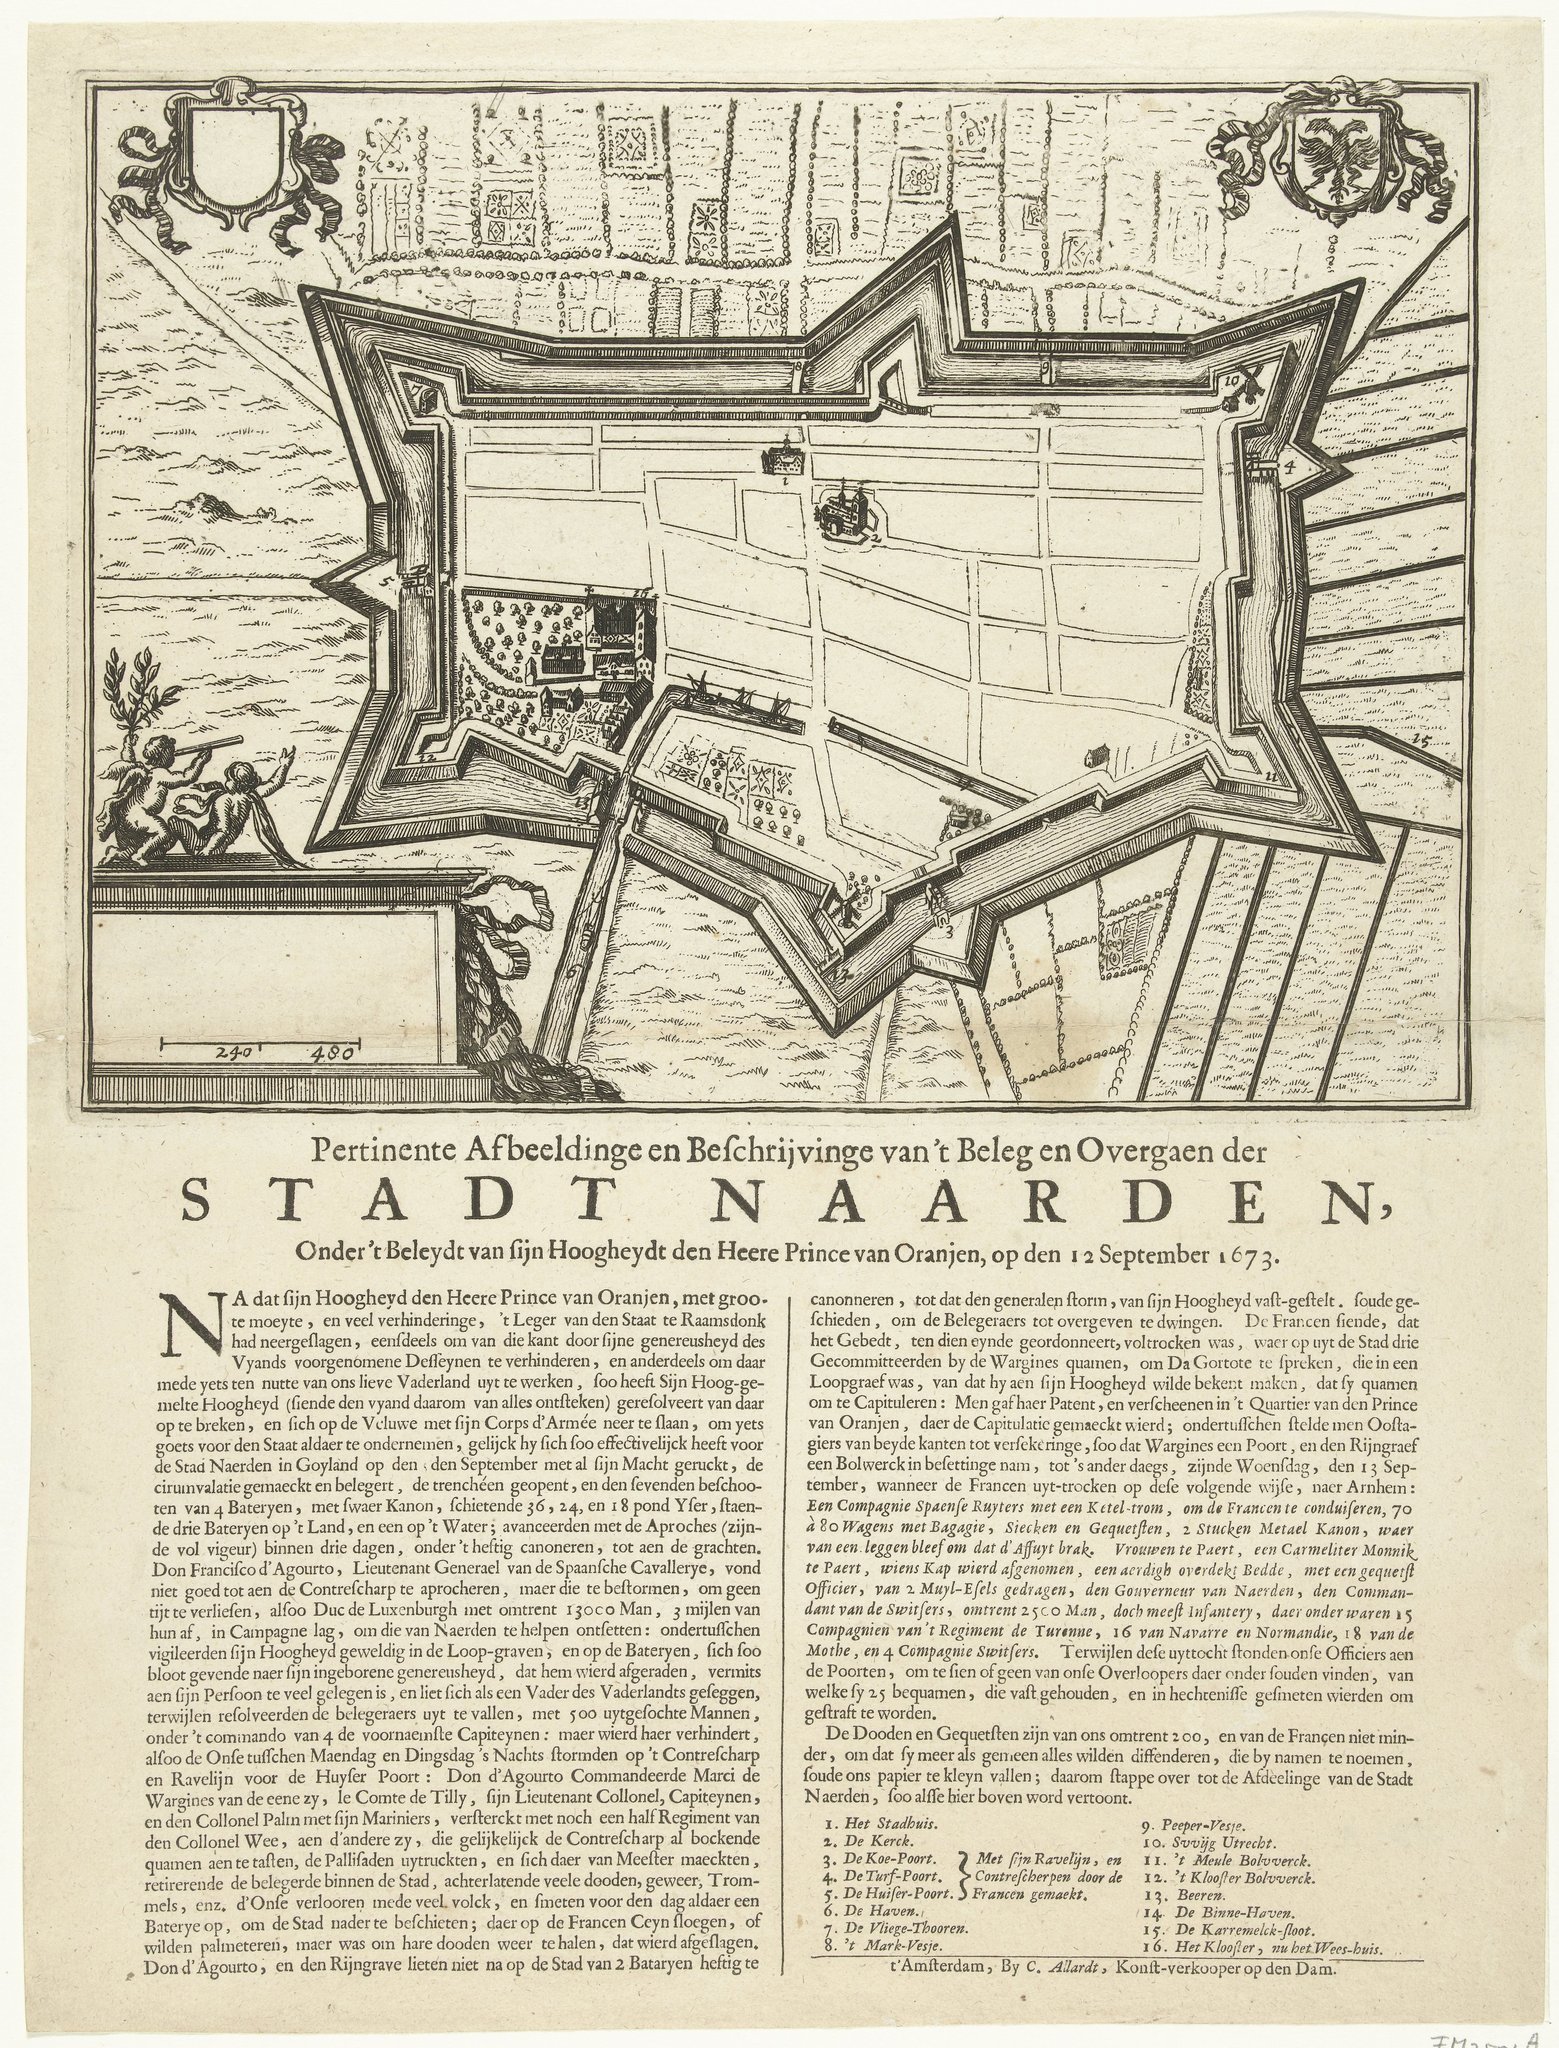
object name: print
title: Pertinente Afbeeldinge en Beschrijvinge van 't Beleg en Overgaen der Stadt Naerden, Onder 't Beleydt van sijn Hoogheydt den Heere Prince van Oranjen, op den 12 September 1673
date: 1673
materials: paper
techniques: etching, letterpress printing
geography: amsterdam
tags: the hague, william iii (prince of orange and king of england, scotland, and ireland), maps of cities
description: Plattegrond van de versterkingen om Naarden, door de prins Willem III belegerd en veroverd op 12 september 1673. Onder de plaat een beschrijving van de gebeurtenissen in 2 kolommen, met de legenda 1-16.